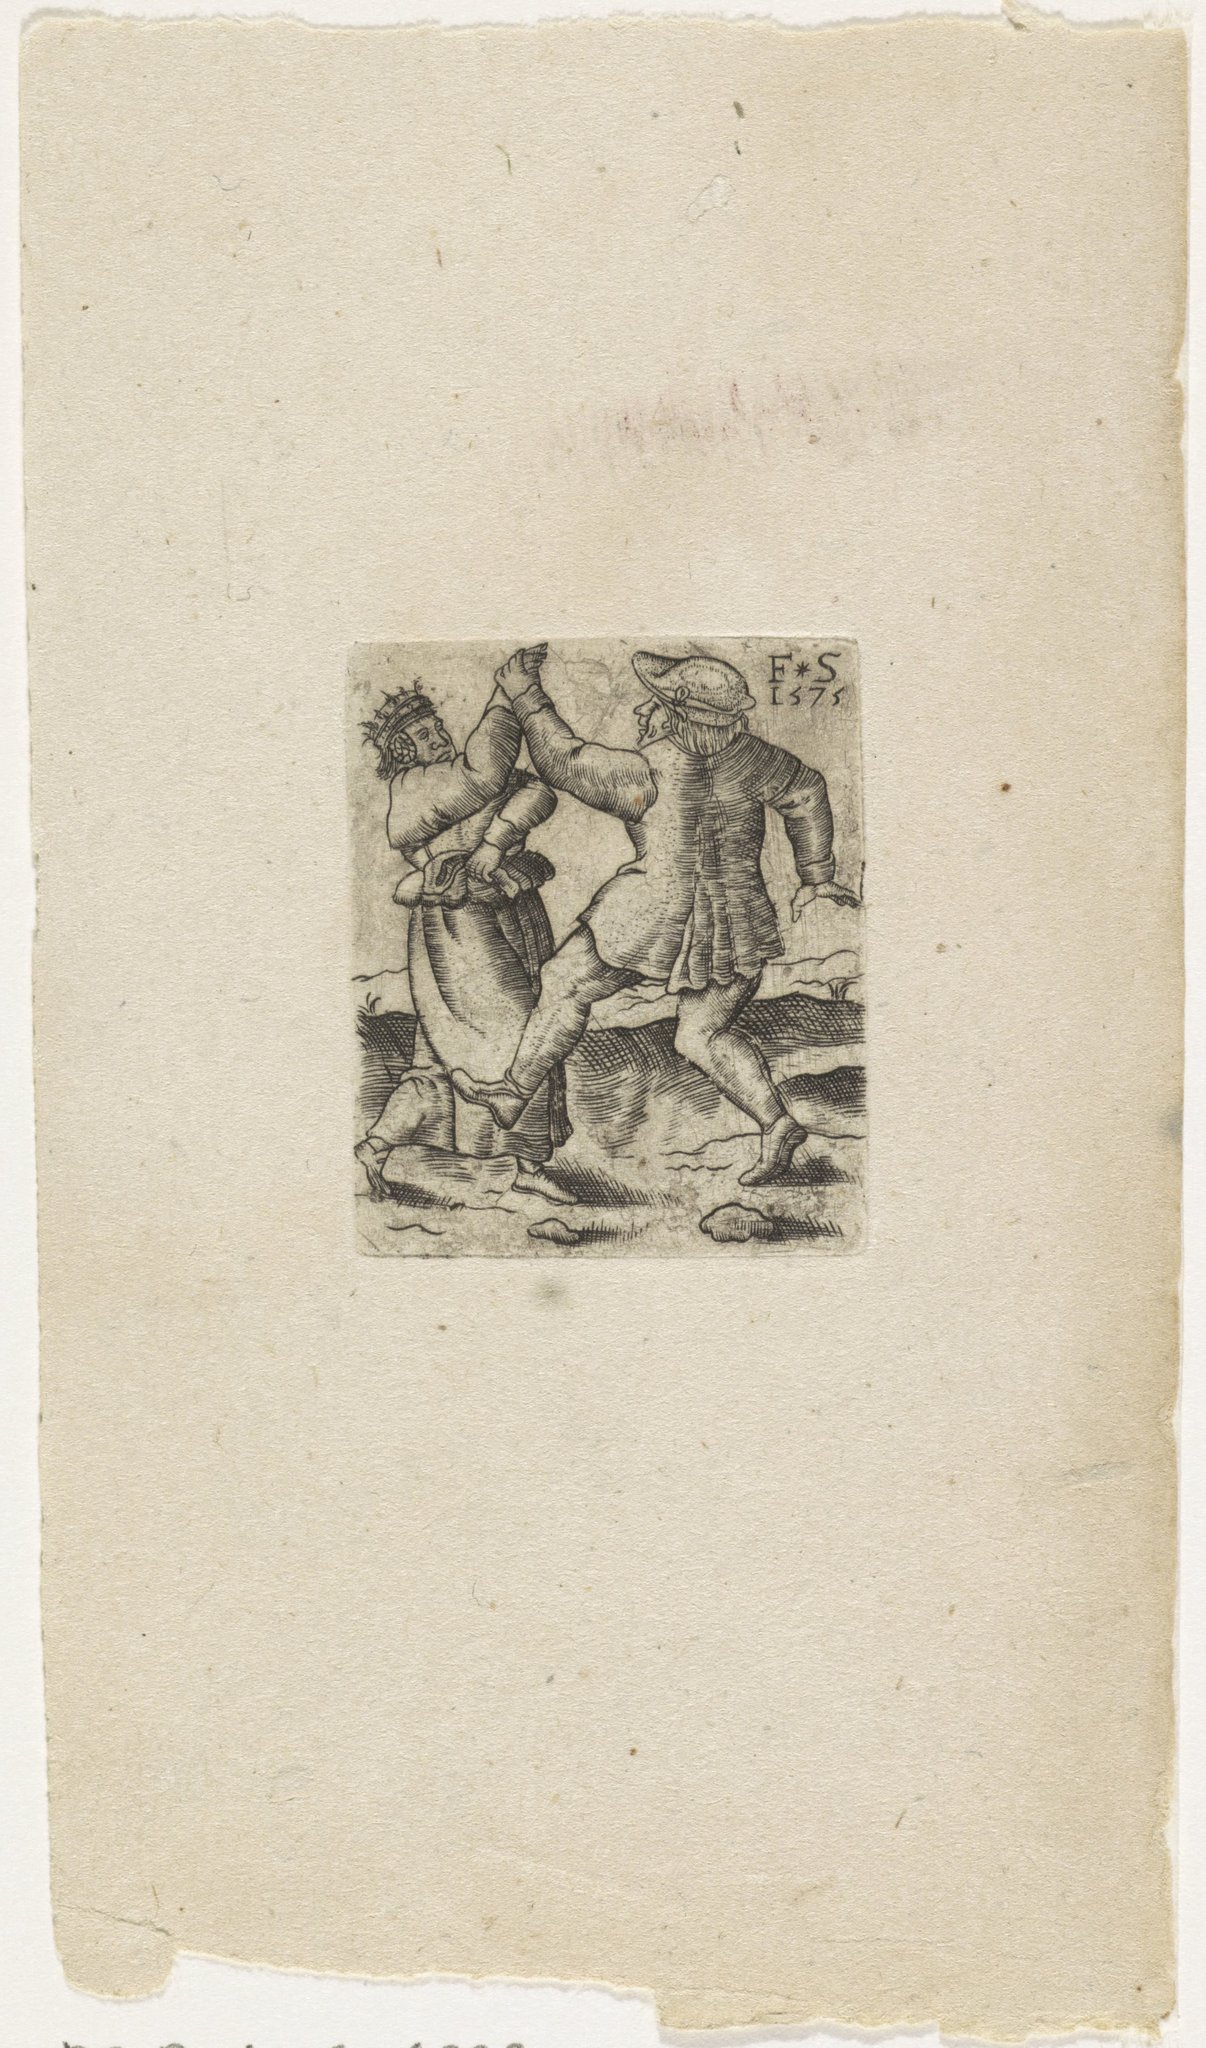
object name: print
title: Dansend boerenpaar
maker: monogrammist fs (16e eeuw)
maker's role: print maker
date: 1575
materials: paper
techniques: engraving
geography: low countries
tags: one pair dancing; man and woman dancing as a couple, farmers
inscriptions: collector's mark: Lugt 2228